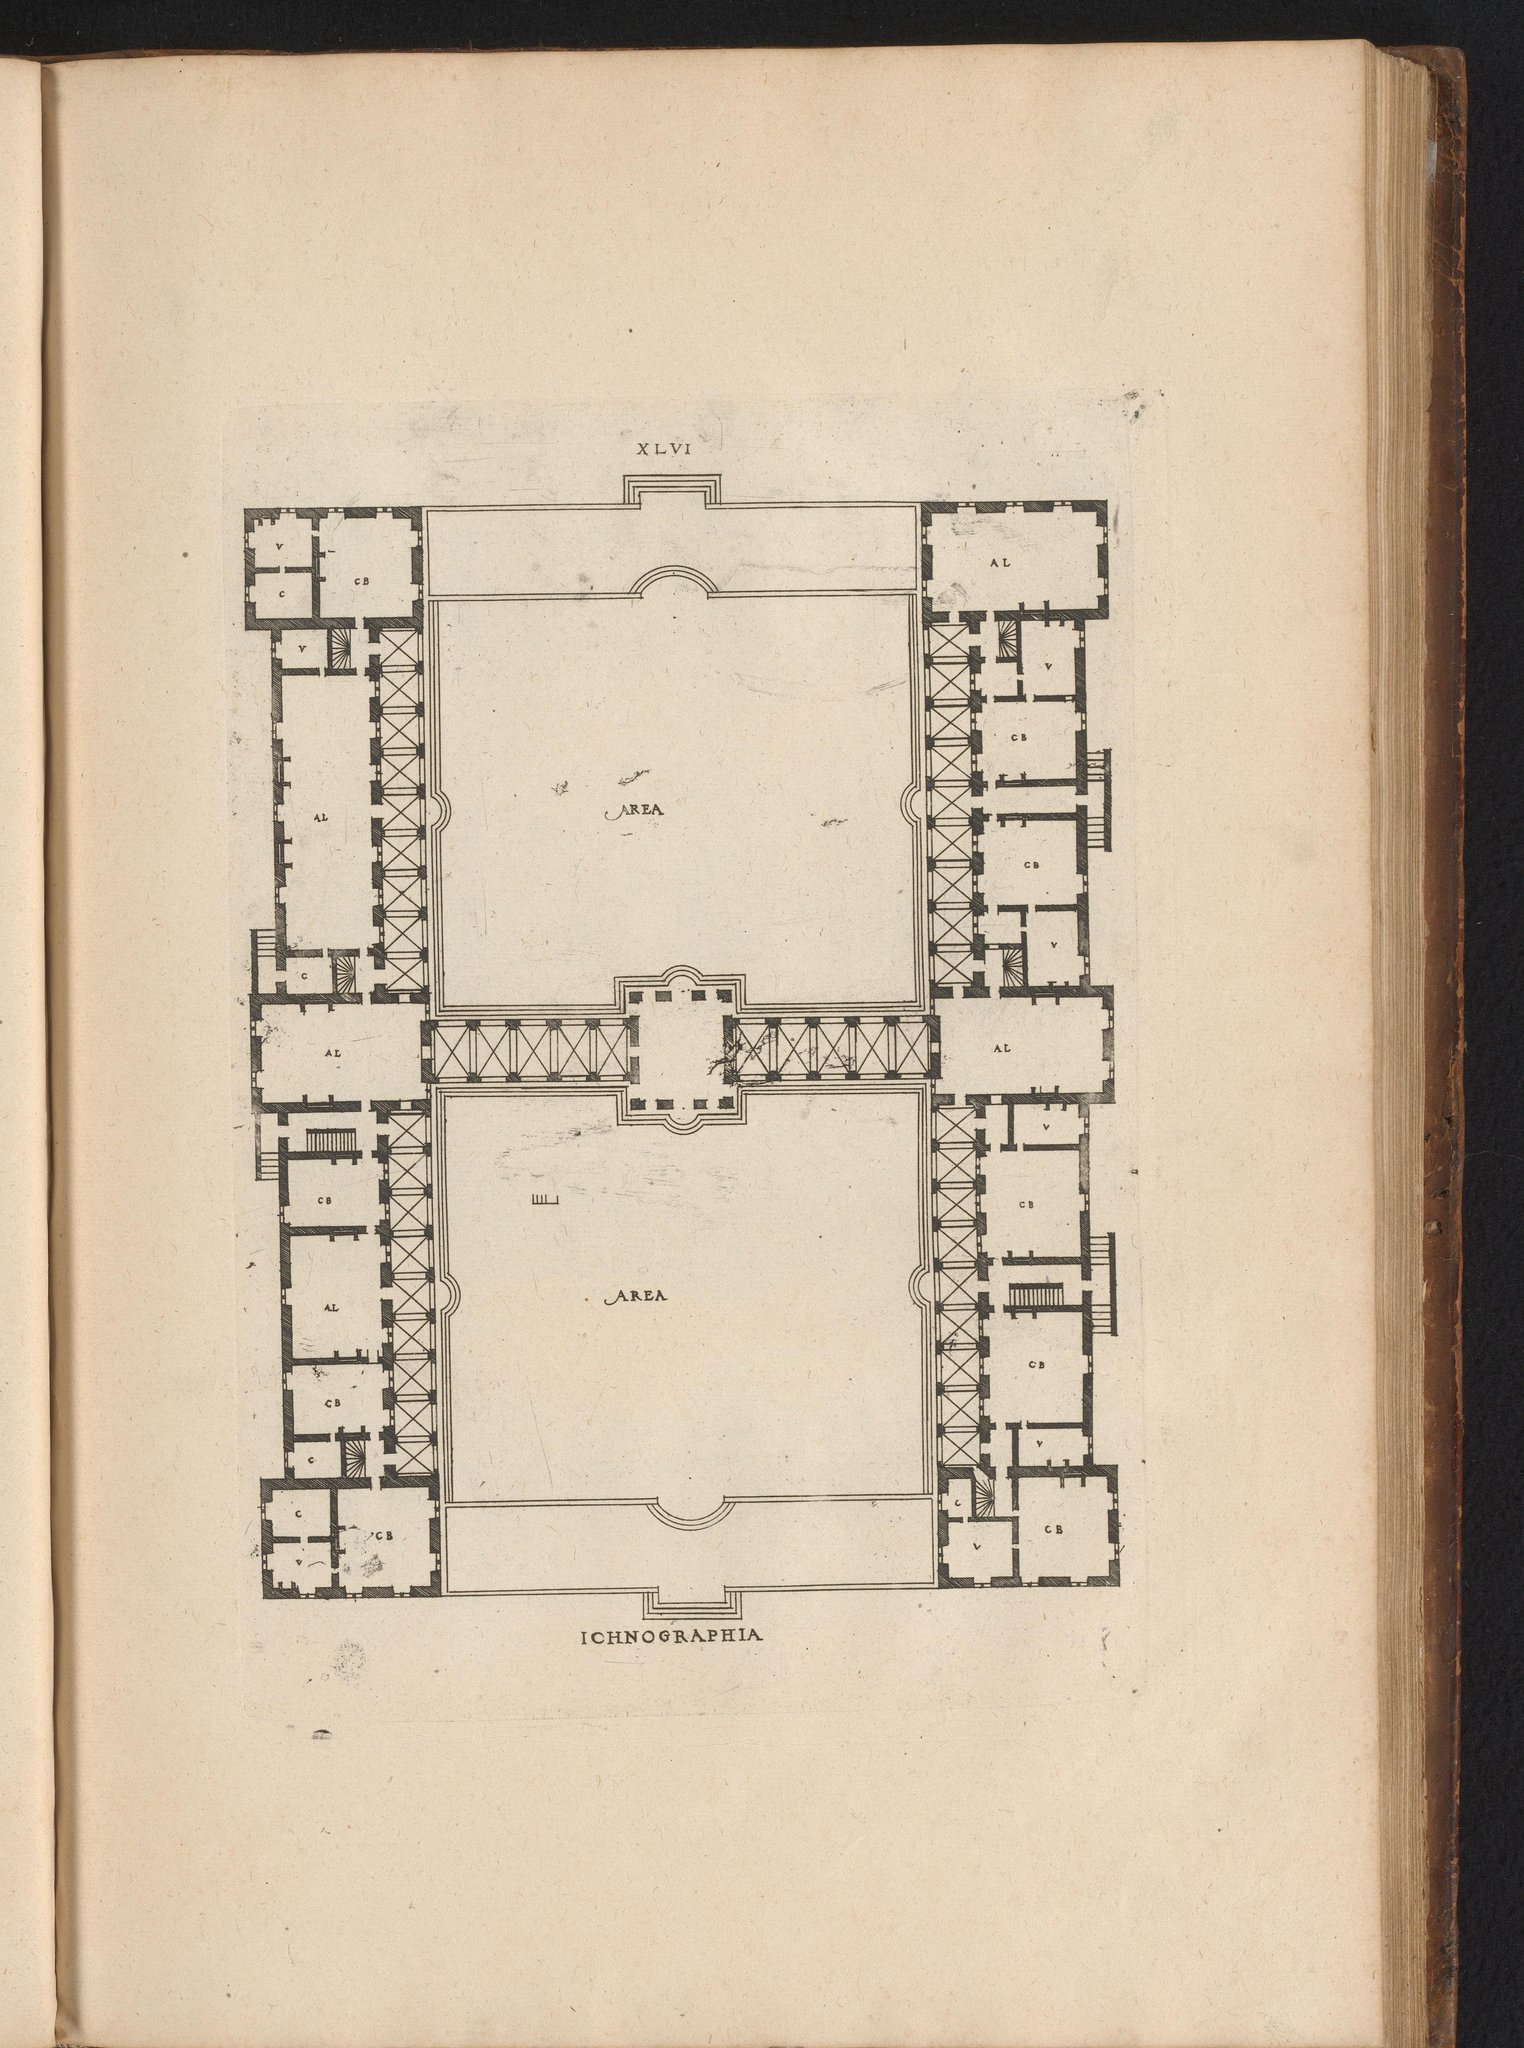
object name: ornament print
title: Plattegrond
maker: jacques androuet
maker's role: draughtsman, print maker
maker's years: 1515-1584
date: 1559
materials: paper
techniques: etching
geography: paris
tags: plan ~ architecture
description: Plattegrond. Aanzicht en plattegrond van architectuur. Genummerd: XLVI. Onderdeel van 'De architectura Iacobi Androuetii du Cerceau' (1559): 69 etsen met 171 voorstellingen van architectuur en ornamentiek.